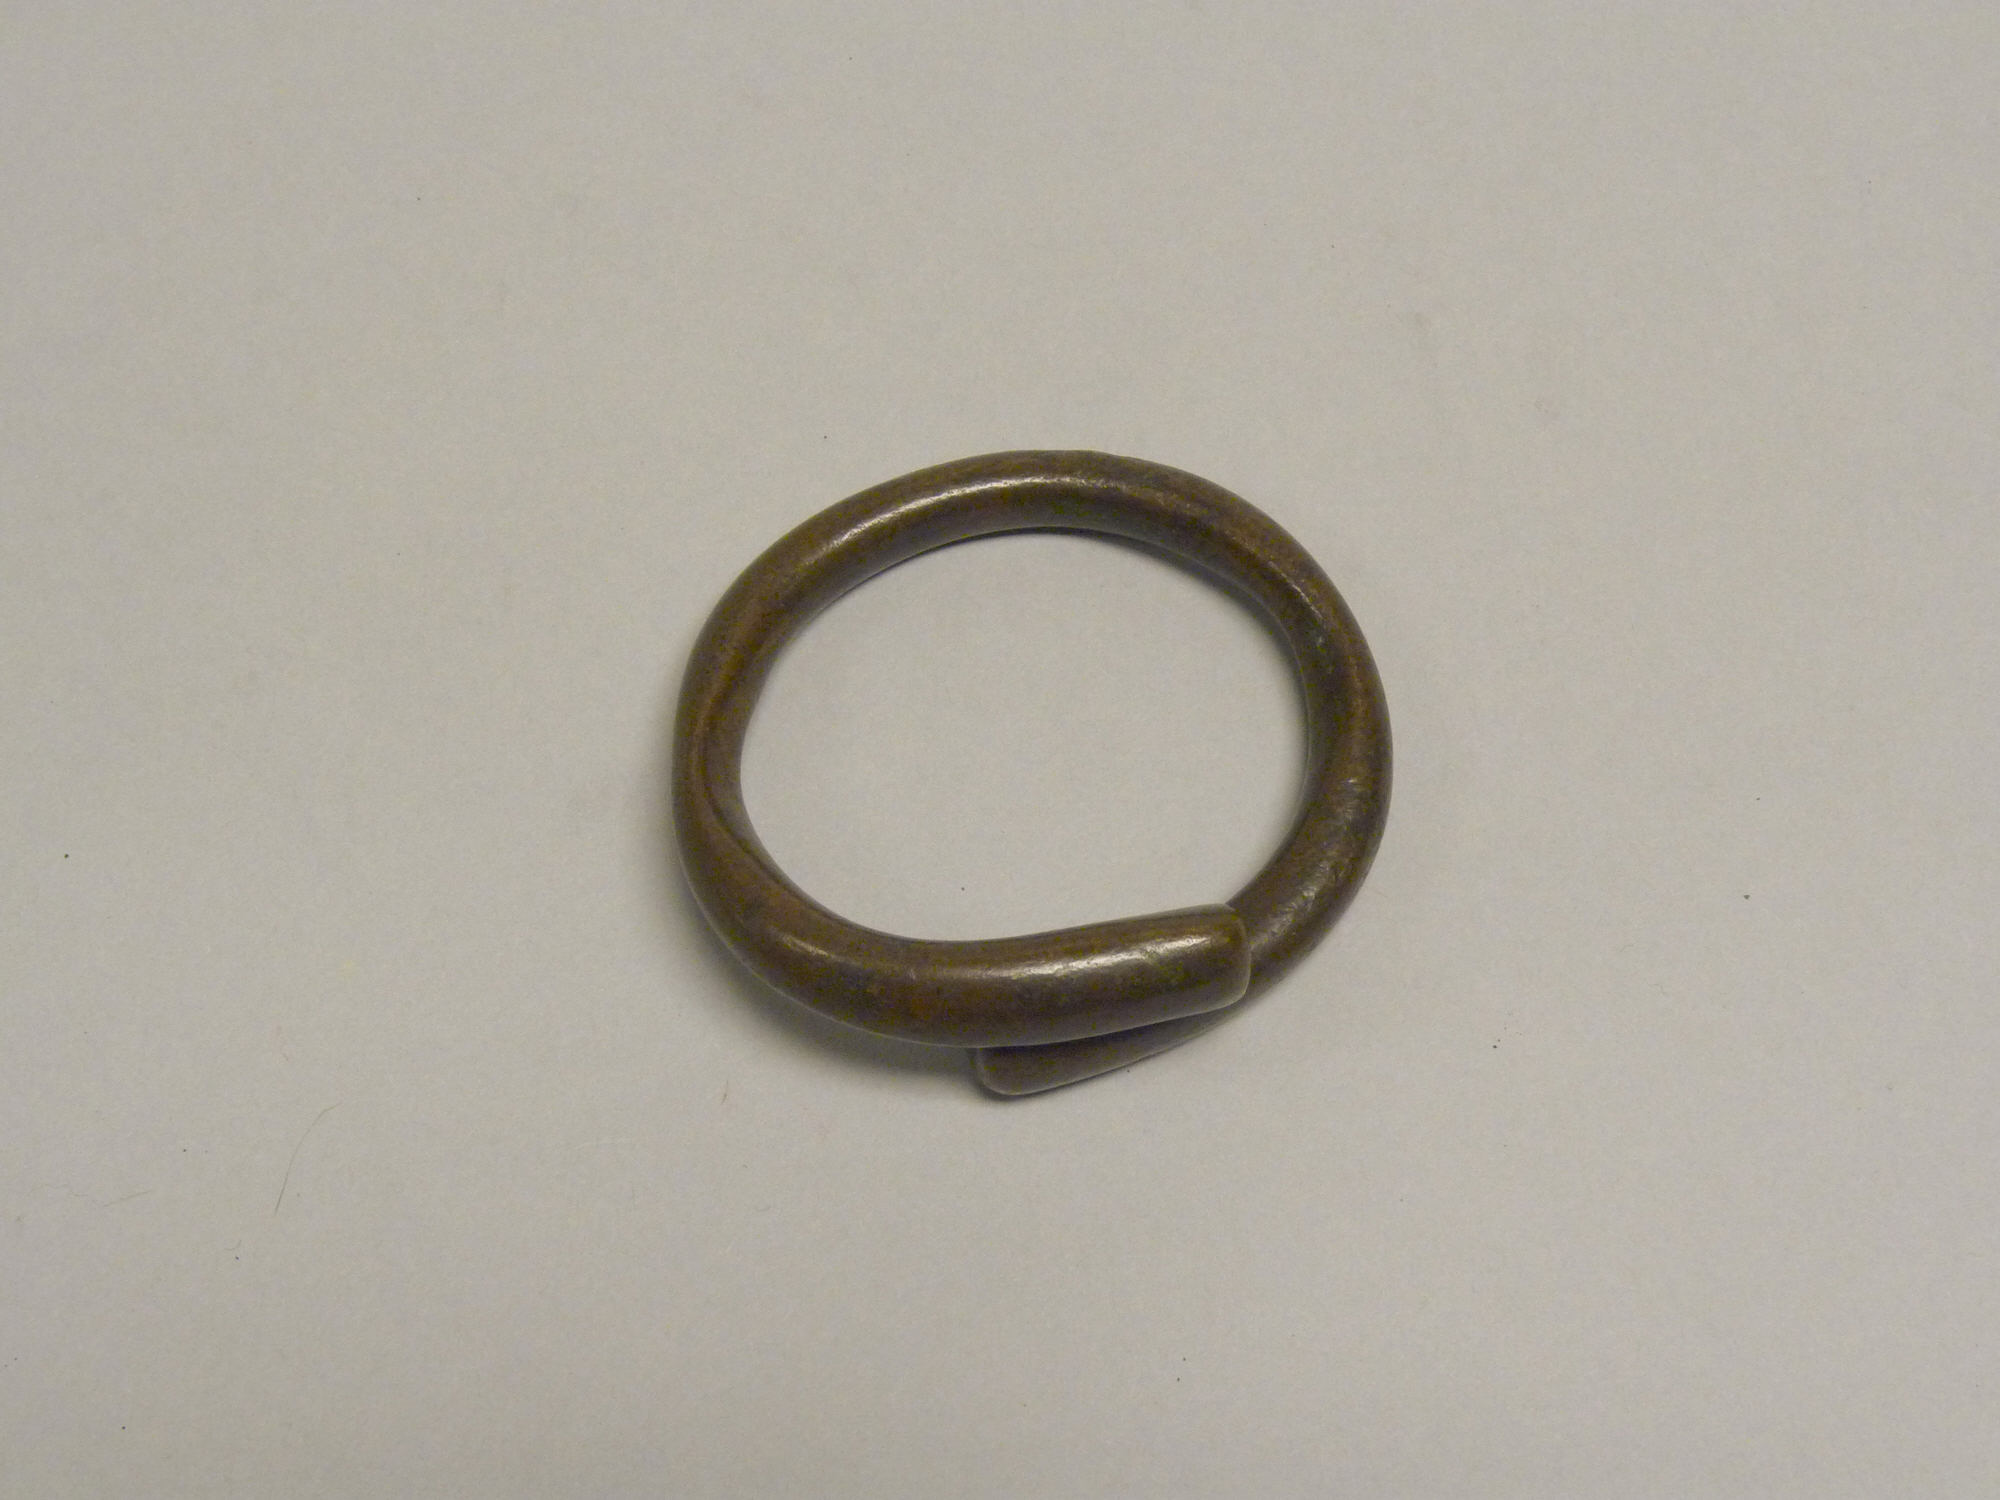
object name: bangle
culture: vietnamese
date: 500 BCE-300 CE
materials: bronze